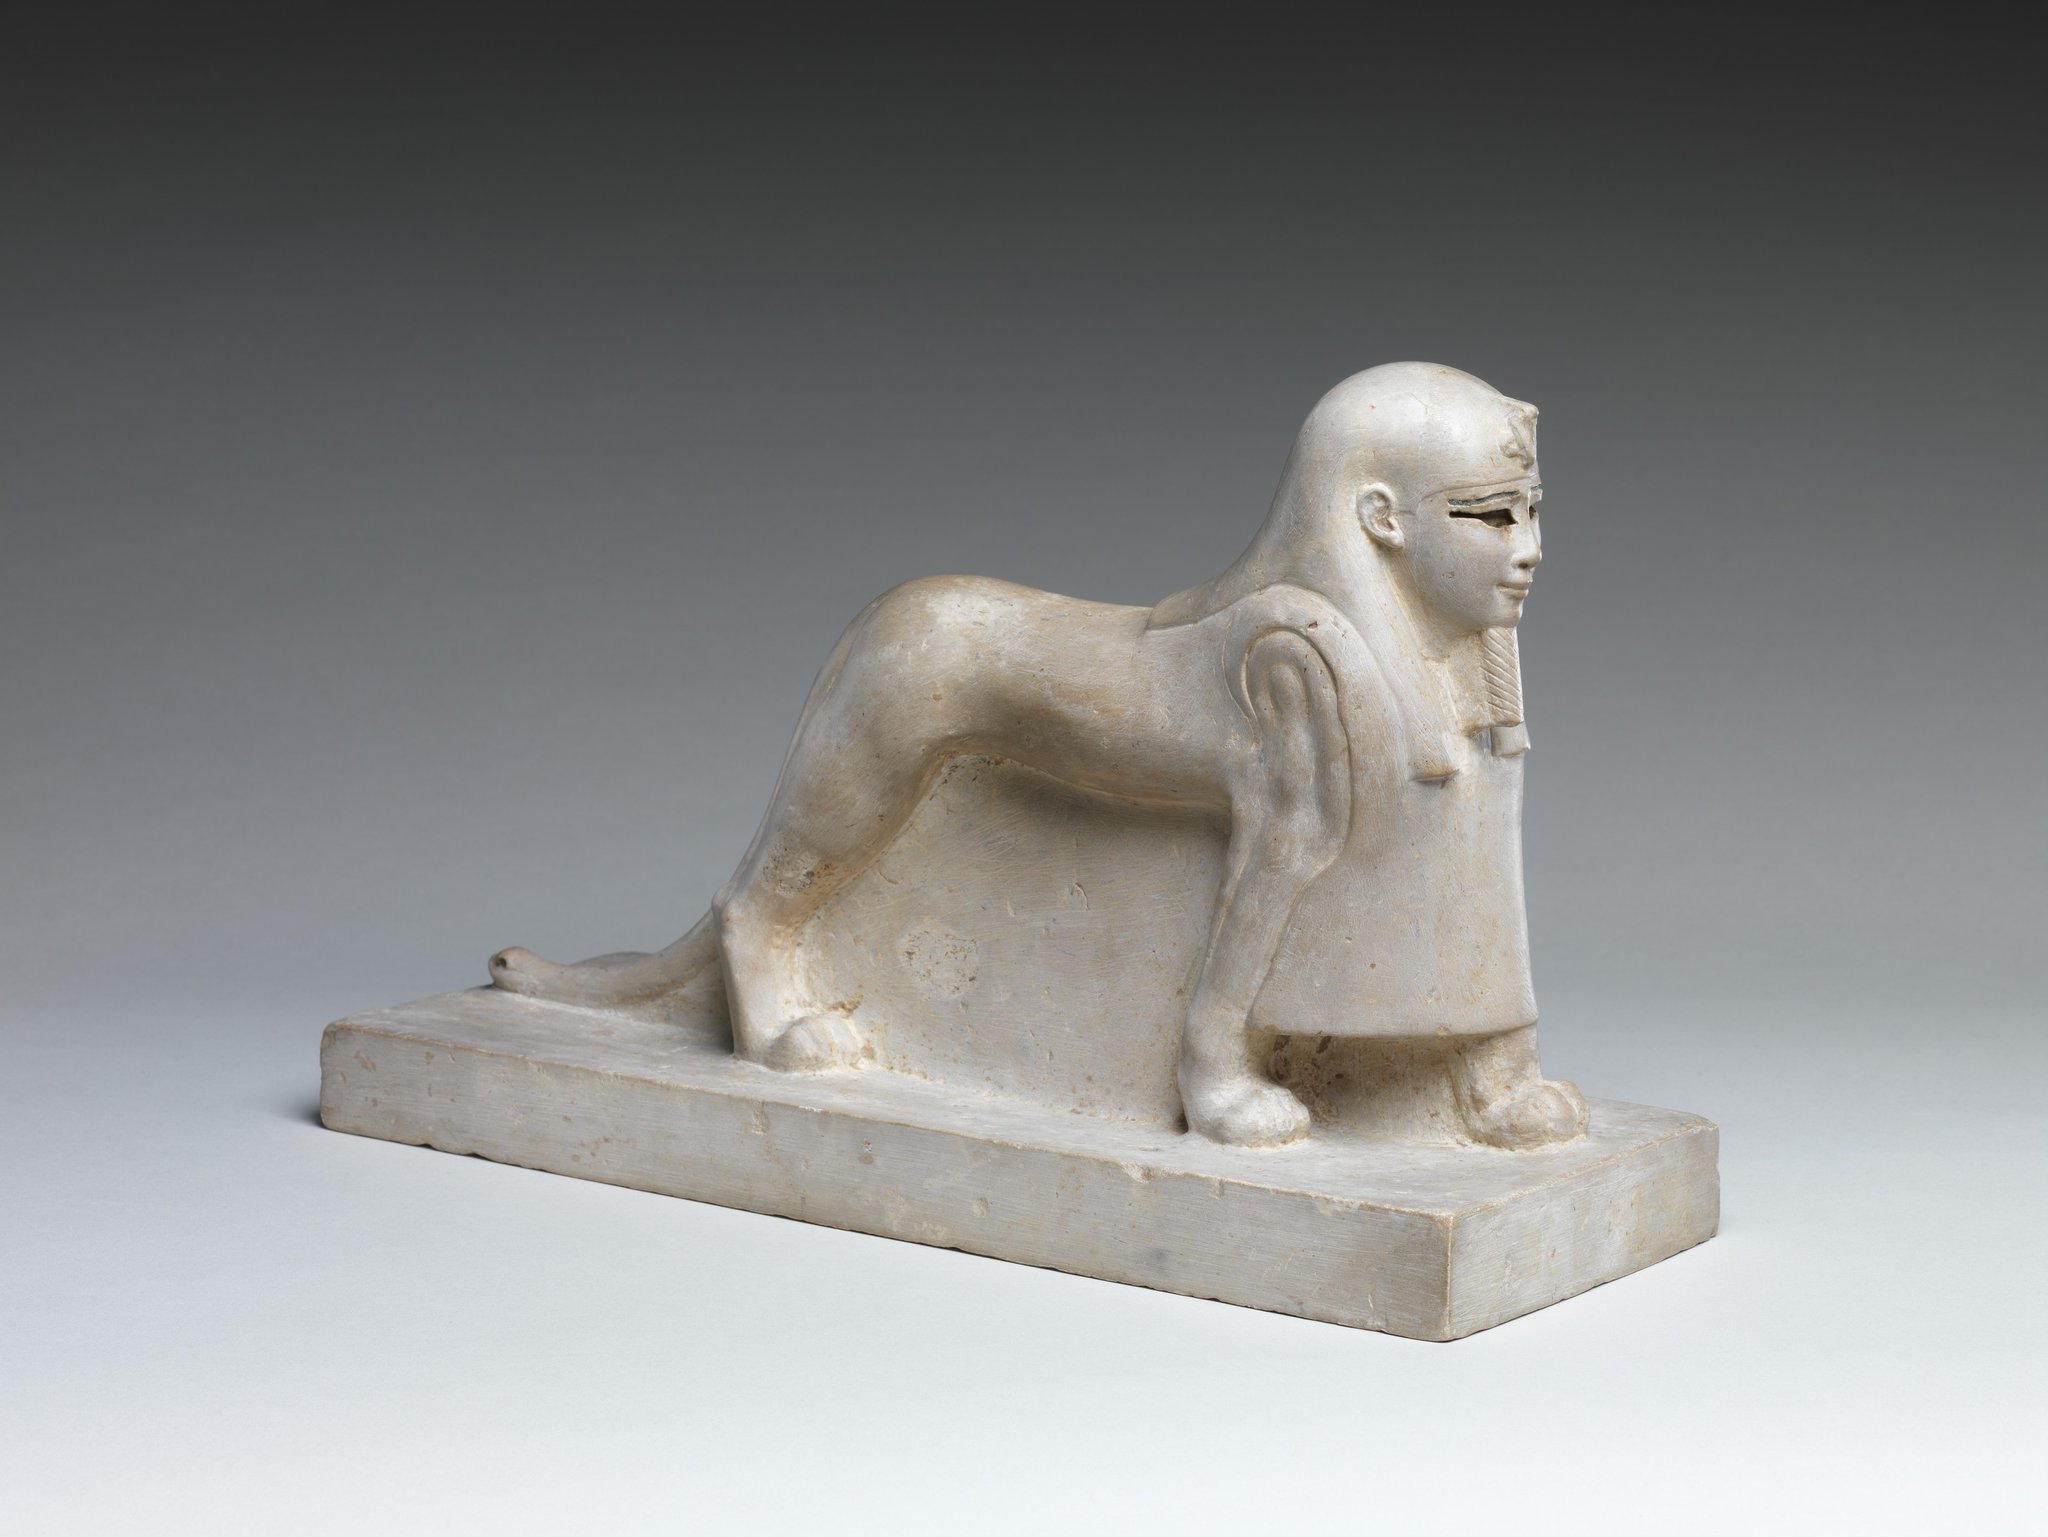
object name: sphinx, tutu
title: Tutu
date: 300-150 BCE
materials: limestone, pigment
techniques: inlay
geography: egypt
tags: sphinx